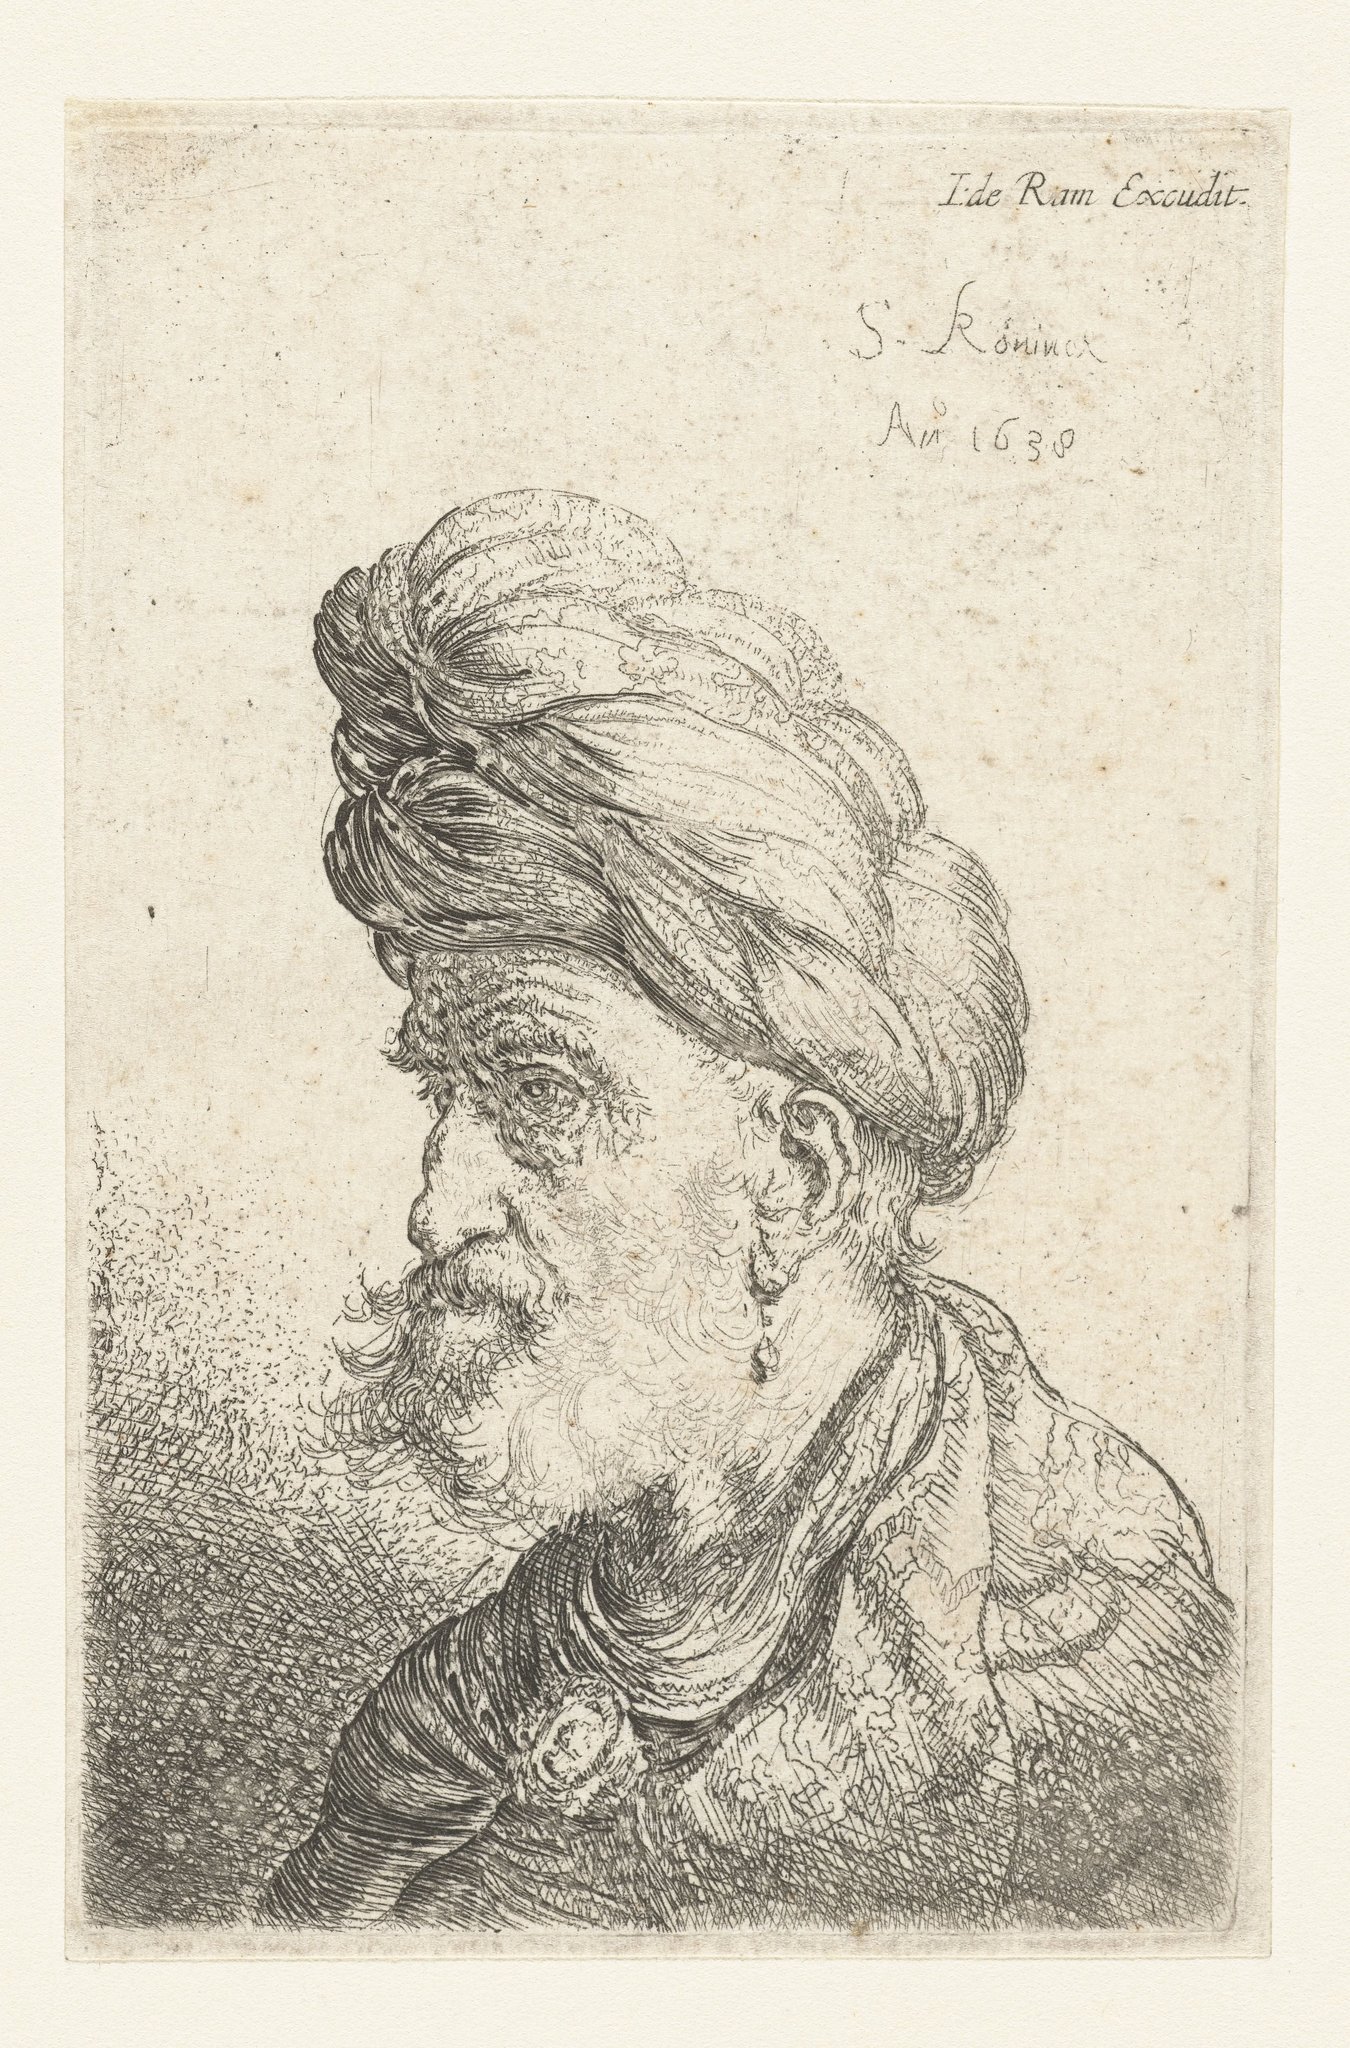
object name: print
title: Buste van een man met tulband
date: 1638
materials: paper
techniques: etching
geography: amsterdam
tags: ear-rings (+ men's clothes), old man, head-gear: turban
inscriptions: collector's mark: Lugt 2228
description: Buste van een oude man met een baard, een hoge tulband en een oorbel.